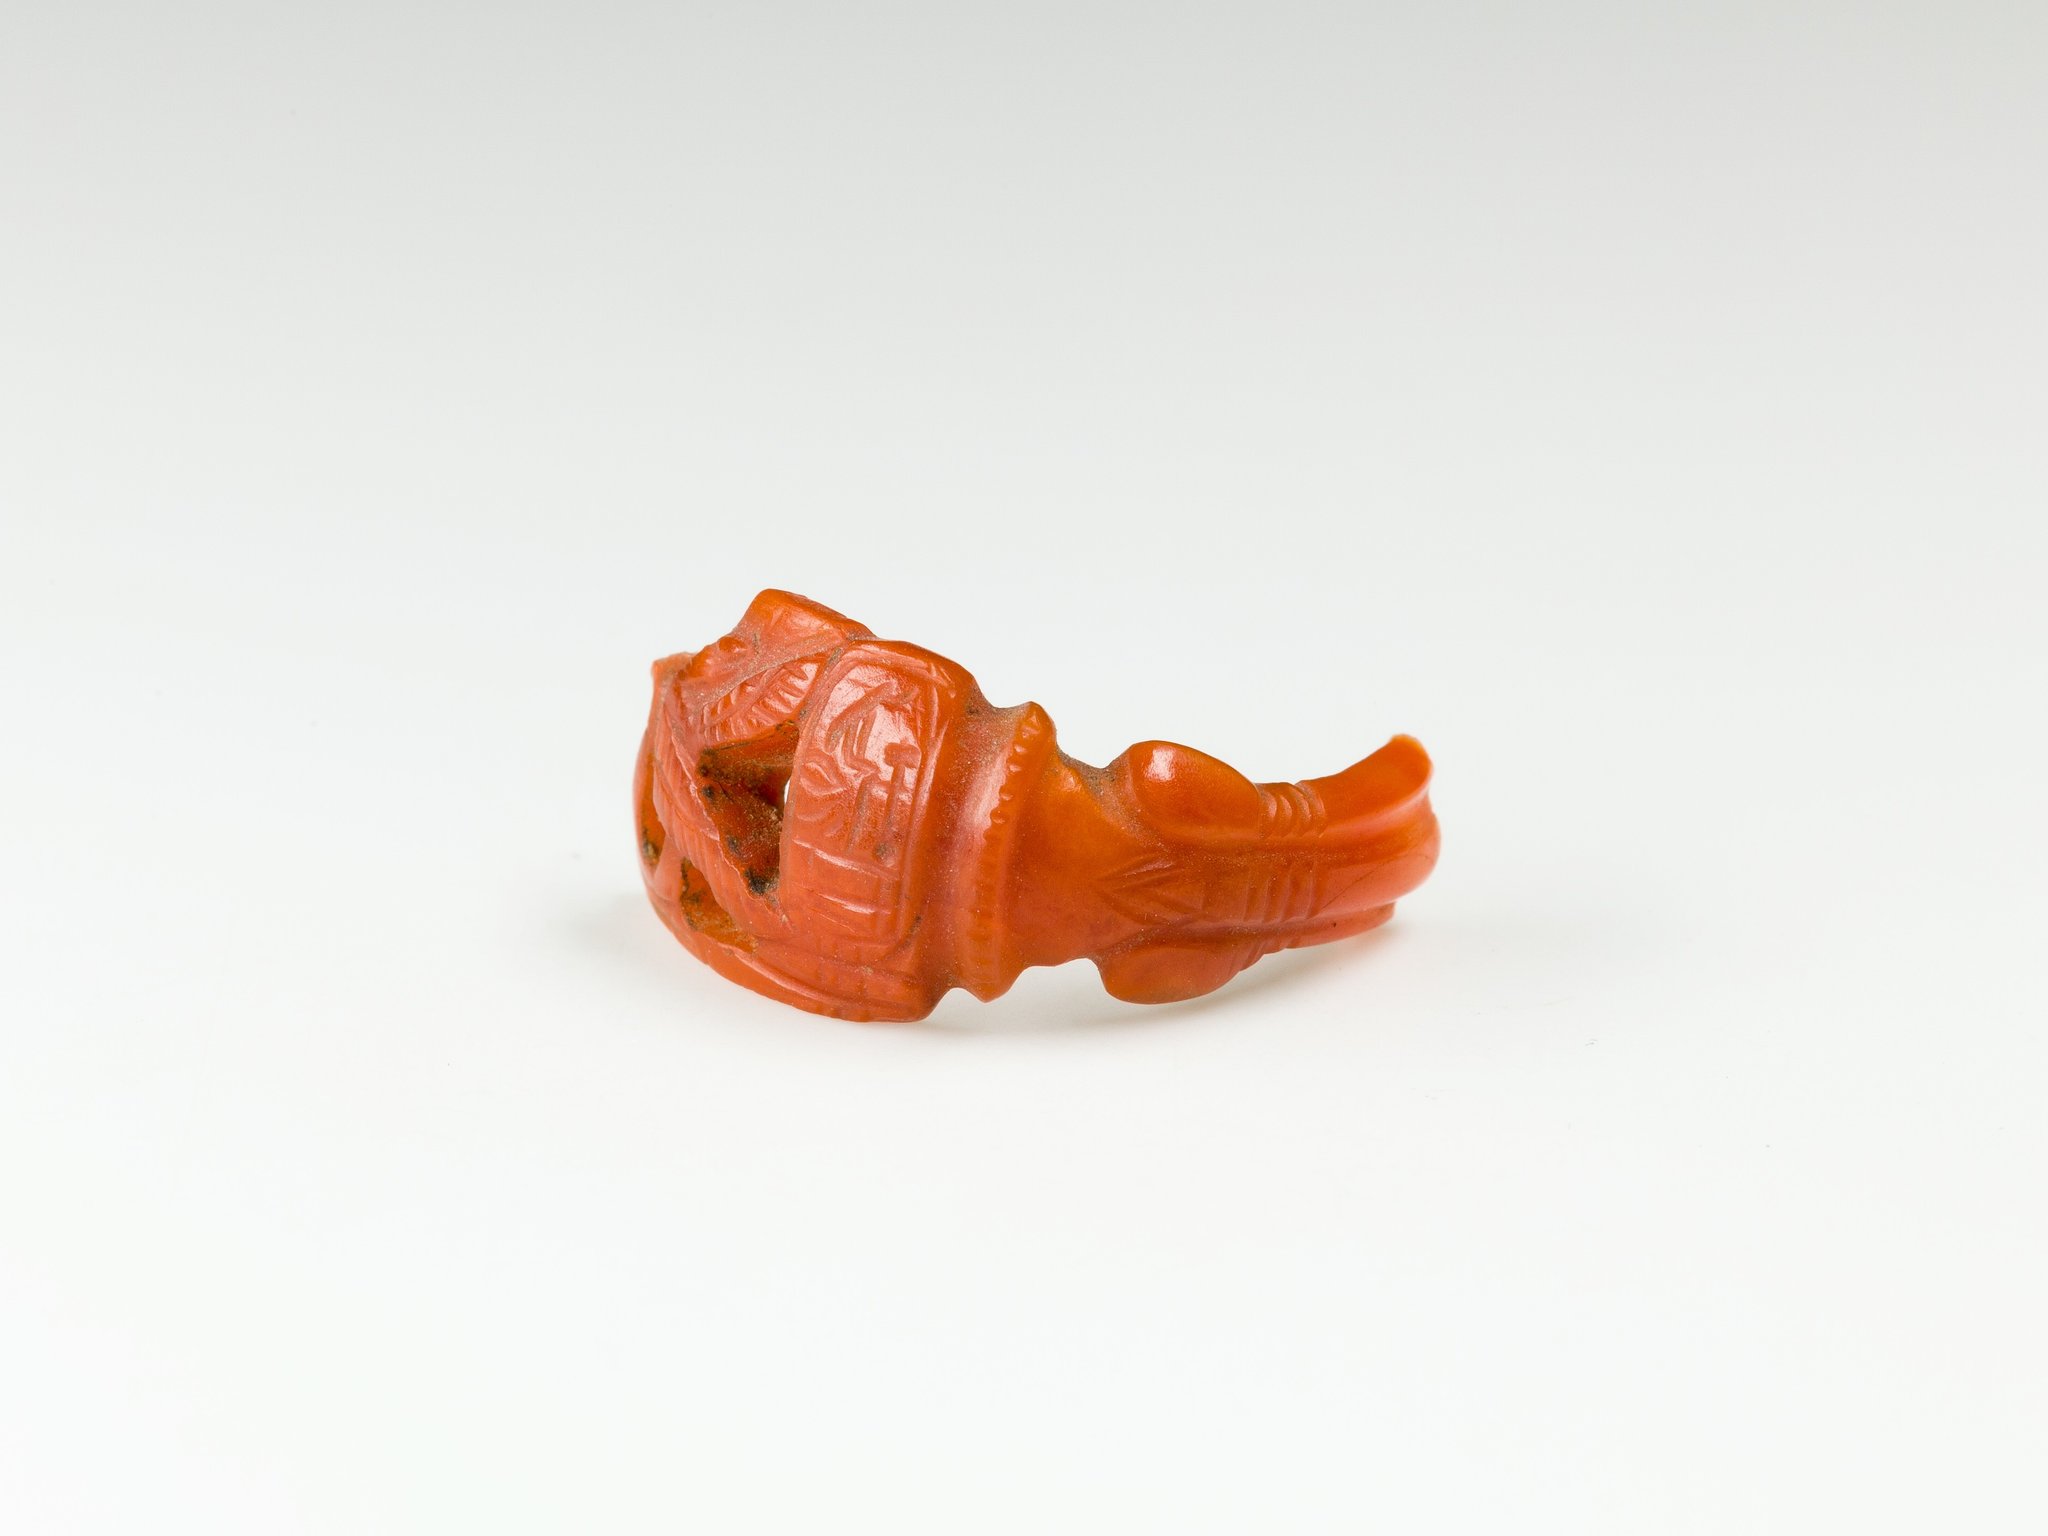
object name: bezel of a ring, nefertari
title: Bezel of a ring of Nefertari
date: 1295-1070 BCE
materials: gemstone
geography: egypt